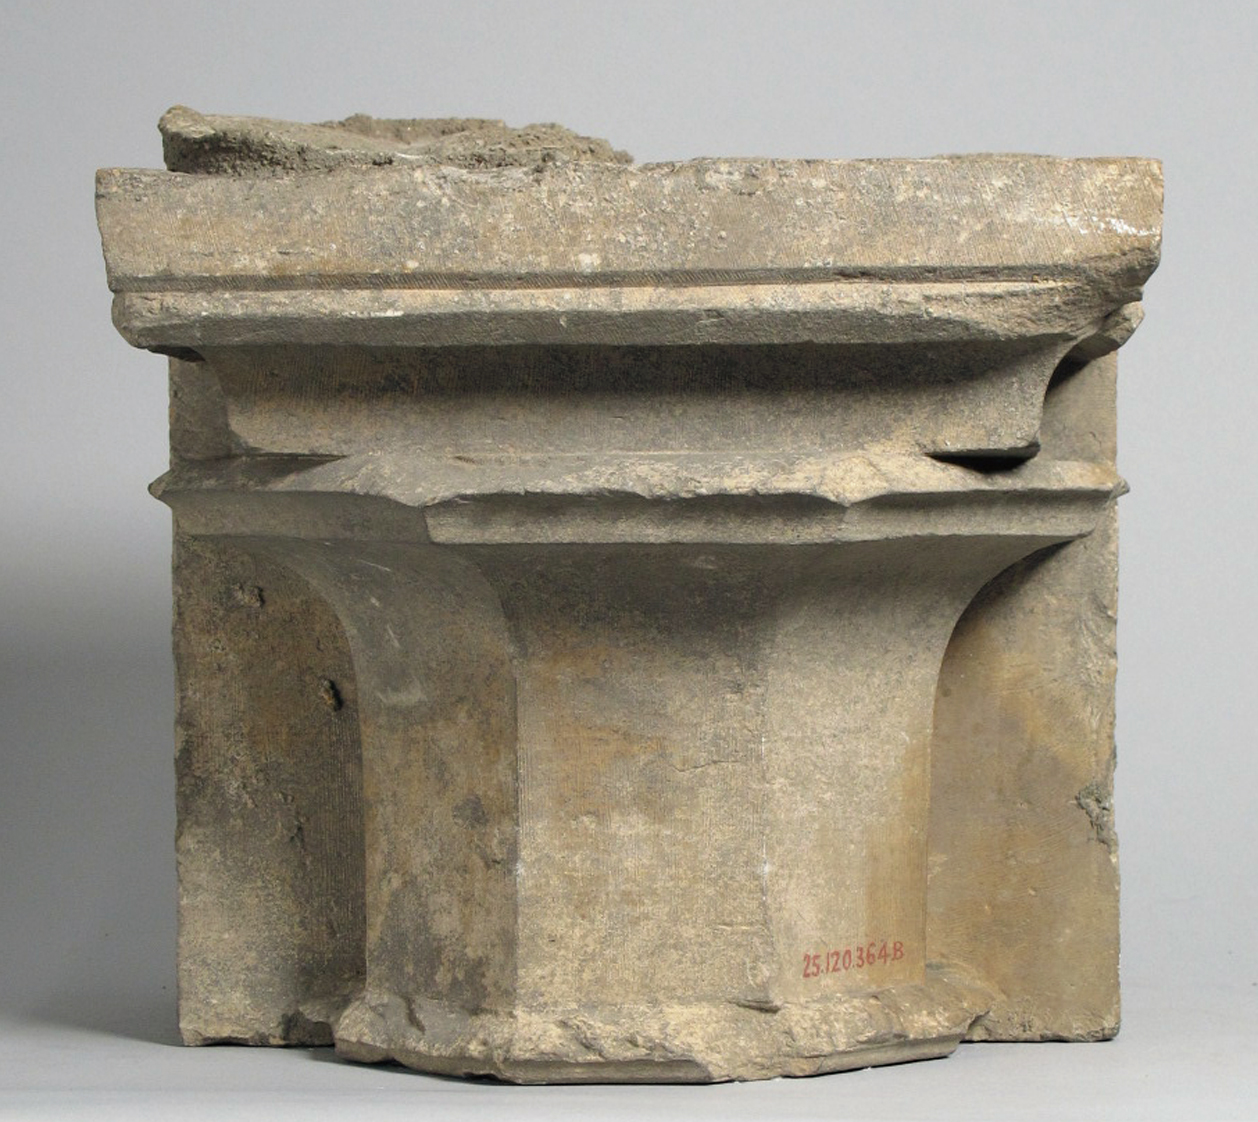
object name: base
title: Engaged Base and Part of Shaft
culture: french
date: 1167-1200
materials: stone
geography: france